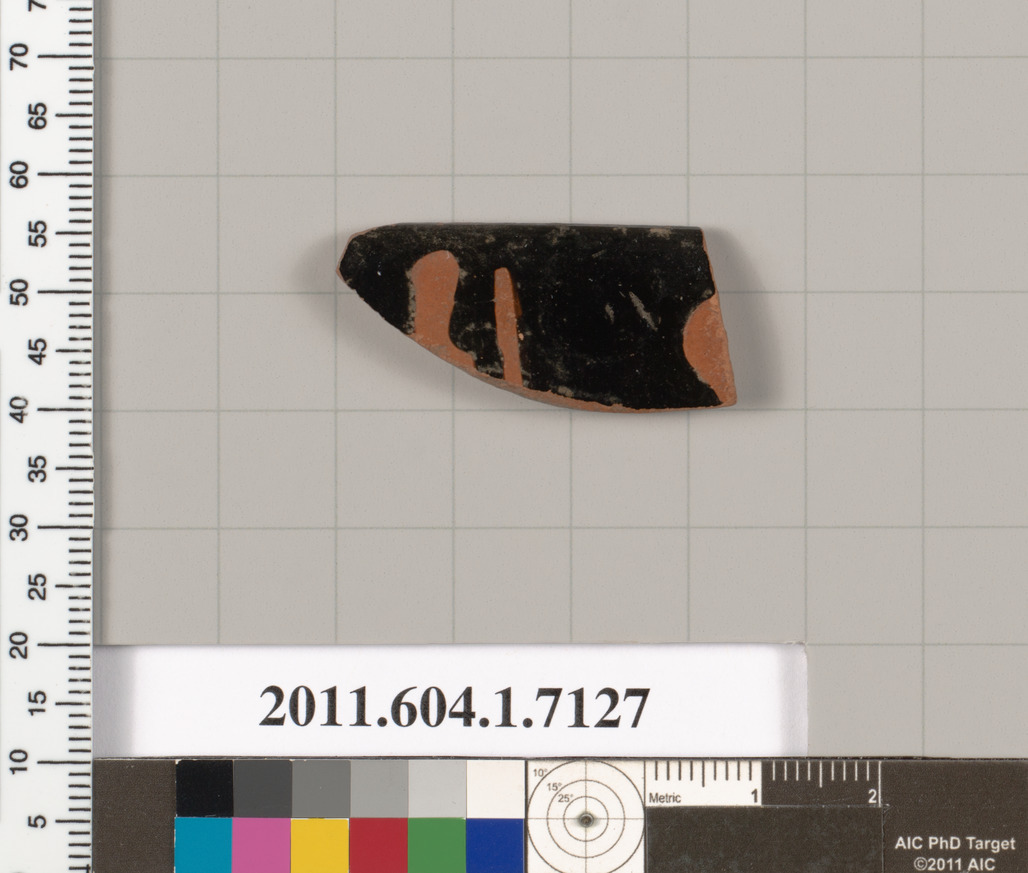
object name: kylix fragment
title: Terracotta rim fragment of a kylix (drinking cup)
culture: greek, attic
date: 475-451 BCE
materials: terracotta